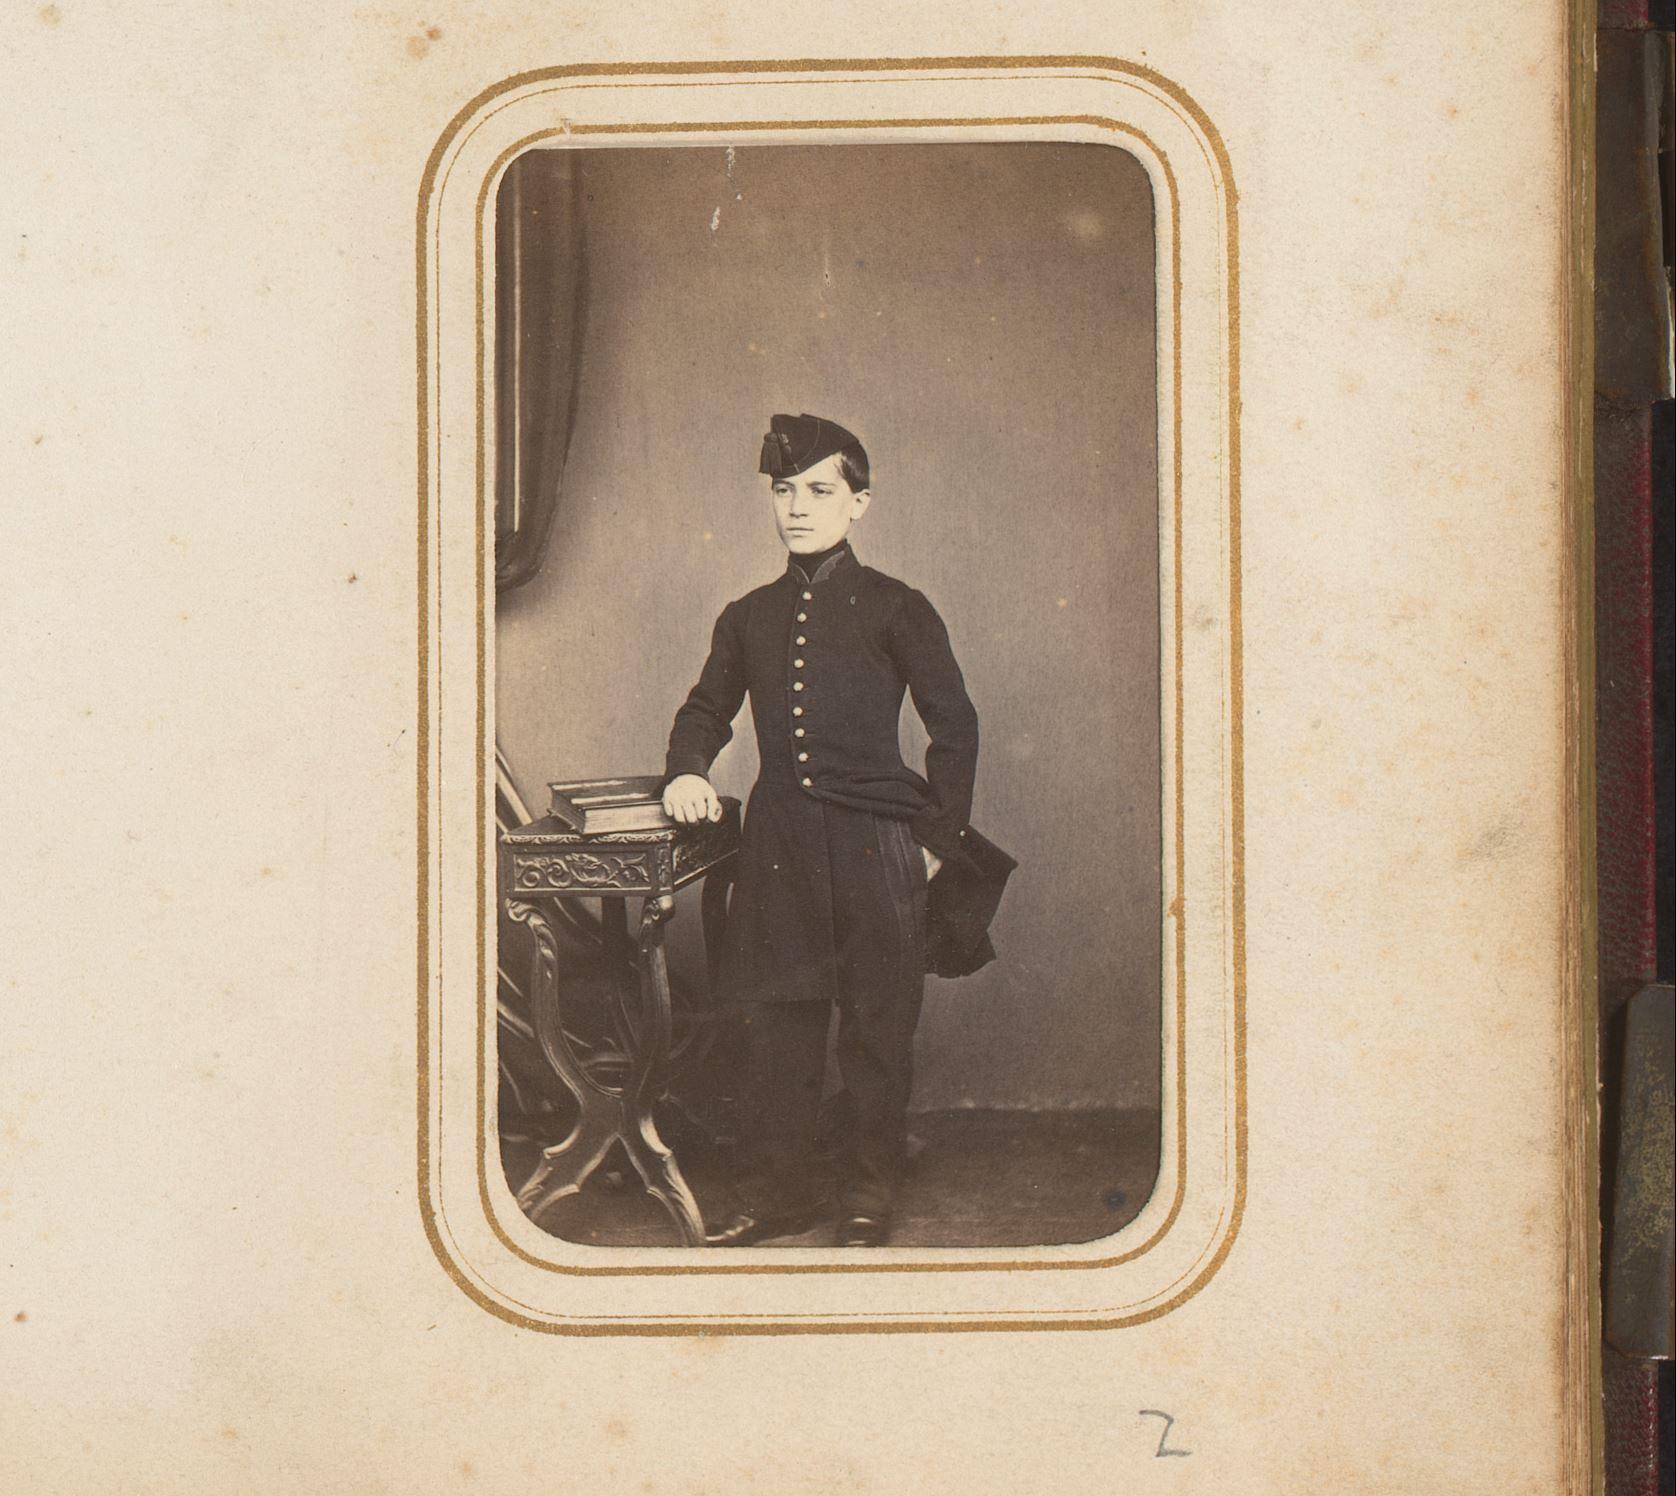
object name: photograph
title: Portret van een jongeman in uniform met boek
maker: charles dherou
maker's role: fotograaf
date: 1870-1880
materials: cardboard, photographic support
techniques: albumen print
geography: grenoble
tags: historical persons, youth, adolescent, (military) uniforms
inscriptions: inscription: ‘Photographie/ Ch. d'Hérou/ Rue du Lycée, 9/ Grenoble’